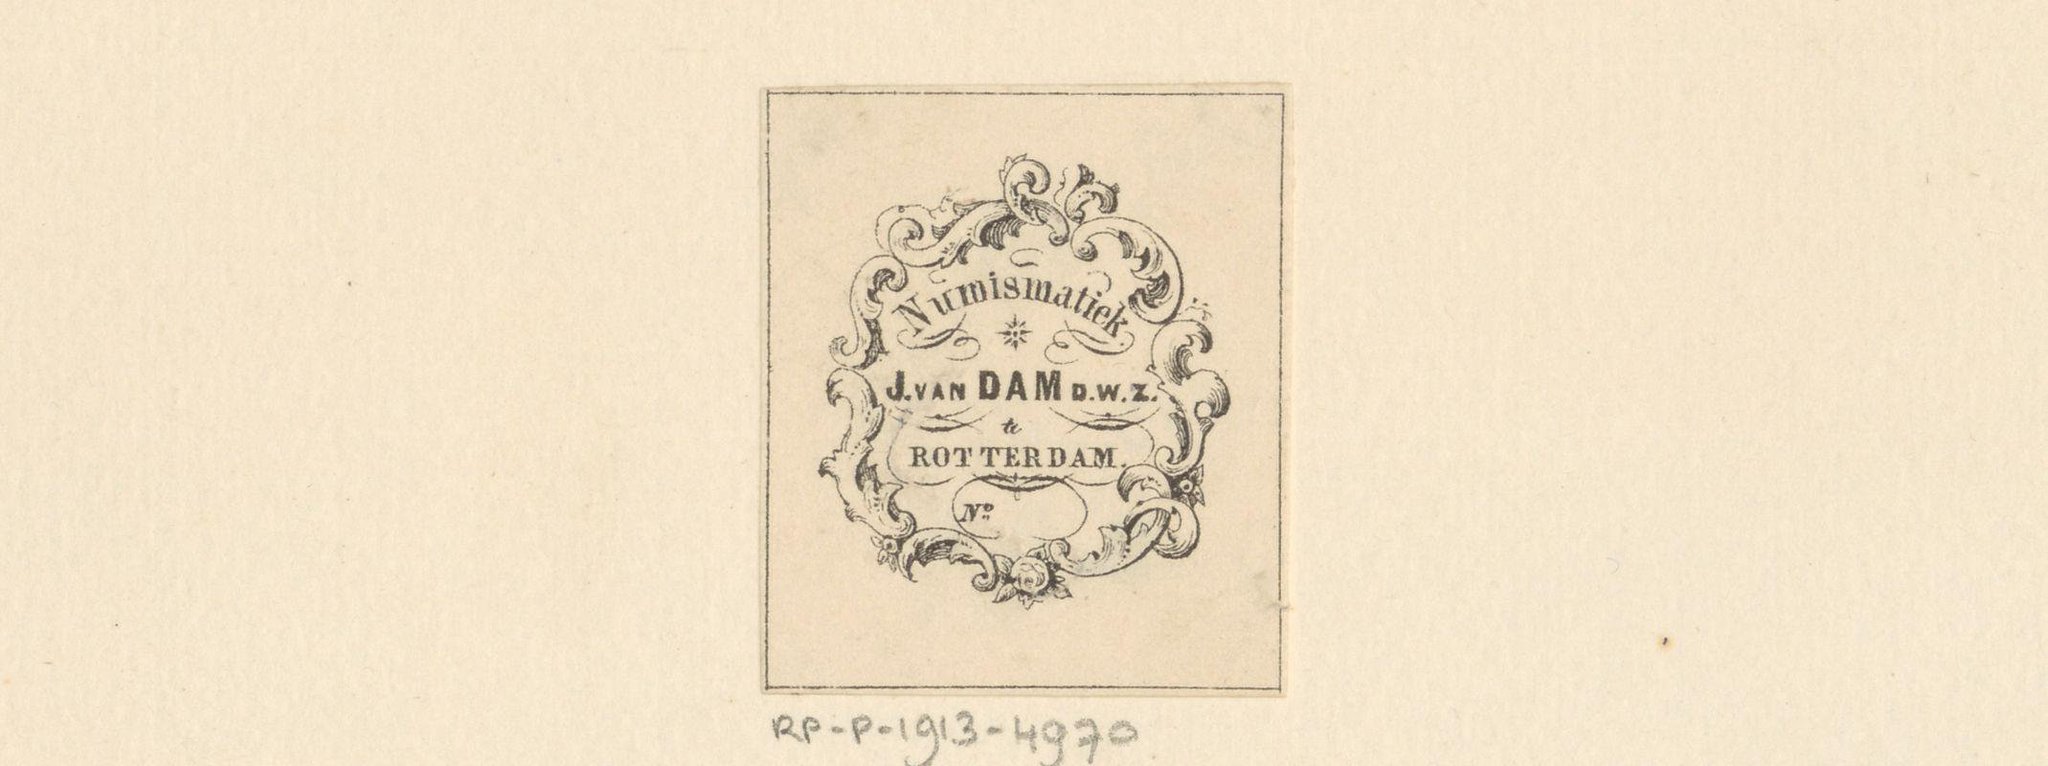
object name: bookplate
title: Naamsetiket van J. van Dam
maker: Anonymous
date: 1850-1913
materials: paper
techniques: engraving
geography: rotterdam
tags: ornament ~ festoon, garland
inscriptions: collector's mark: Lugt 2233, collector's mark: Lugt 2760